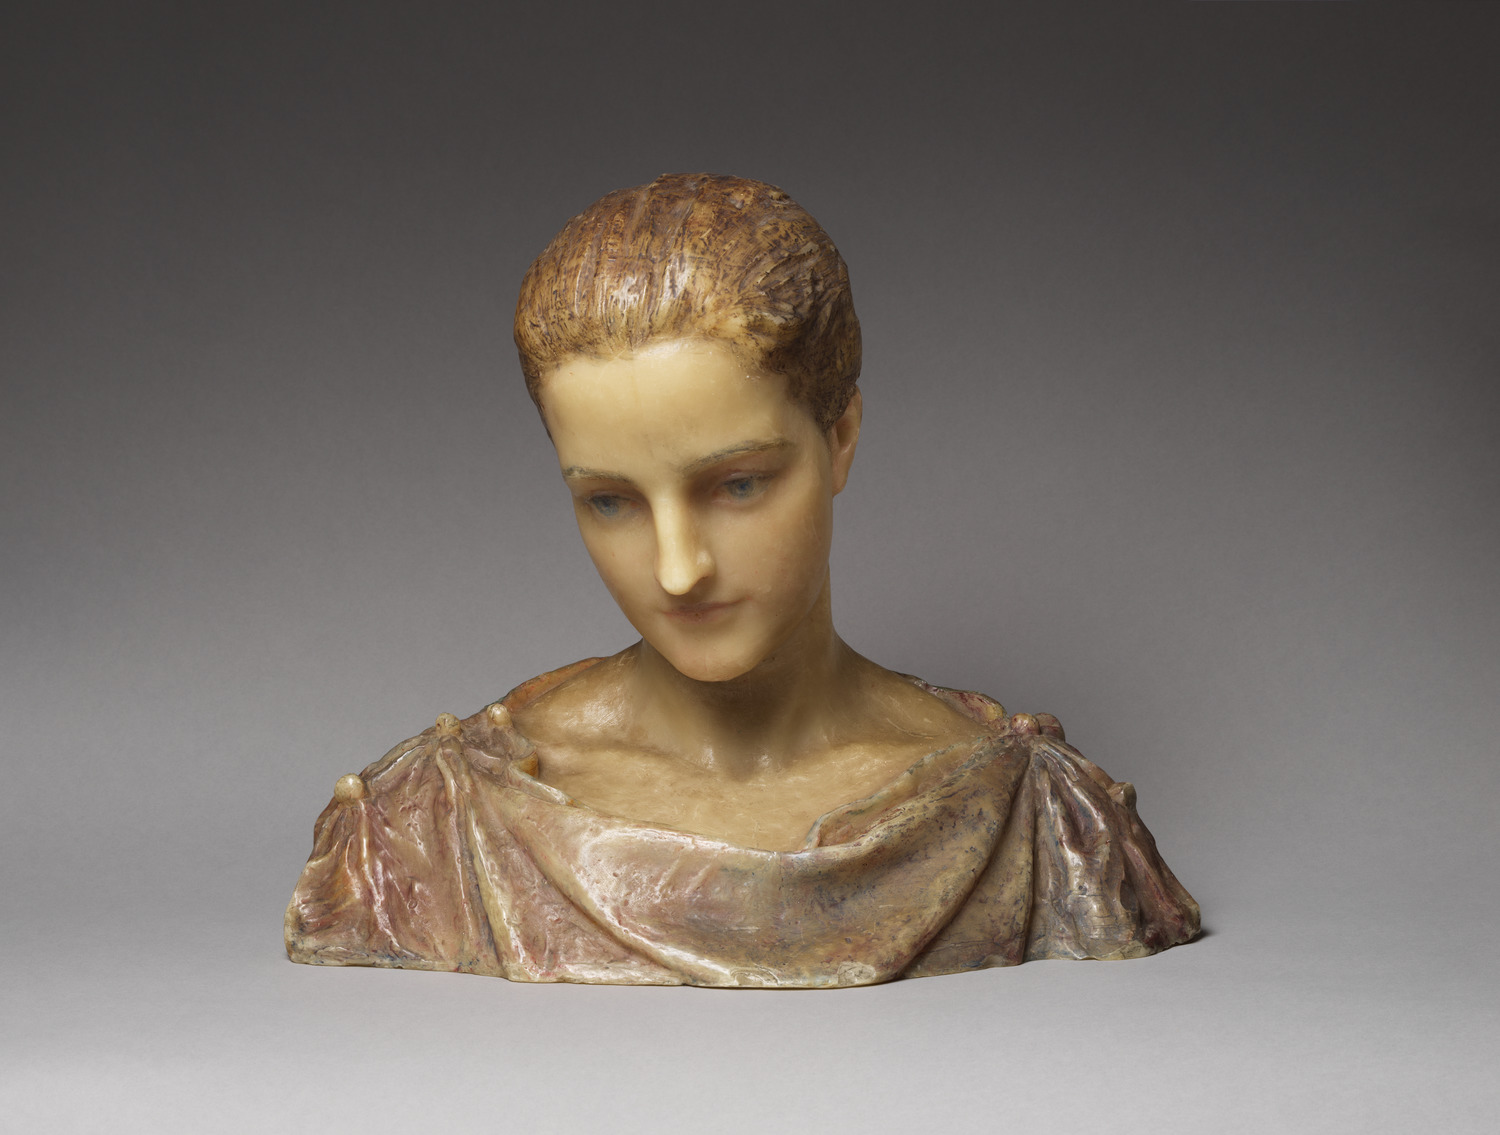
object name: bust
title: Louise Adele Dickerson Gould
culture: american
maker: augustus saint-gaudens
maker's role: artist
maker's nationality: american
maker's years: 1848-1907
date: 1894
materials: wax